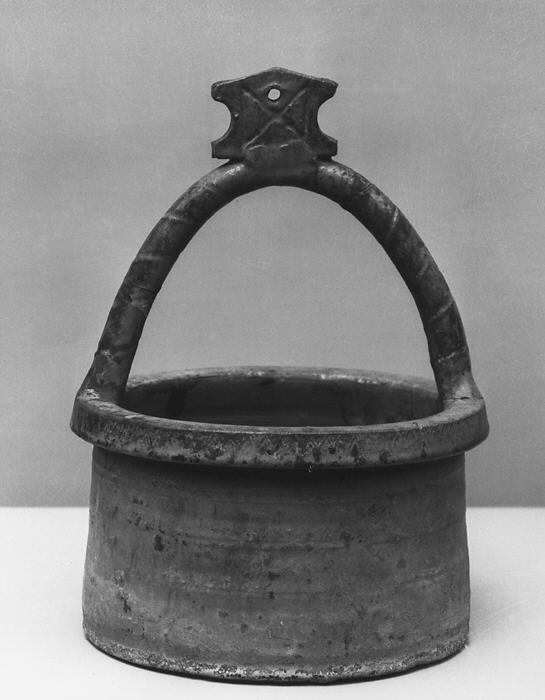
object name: wellhead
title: Well Head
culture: chinese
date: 206 BCE-220 CE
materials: pottery